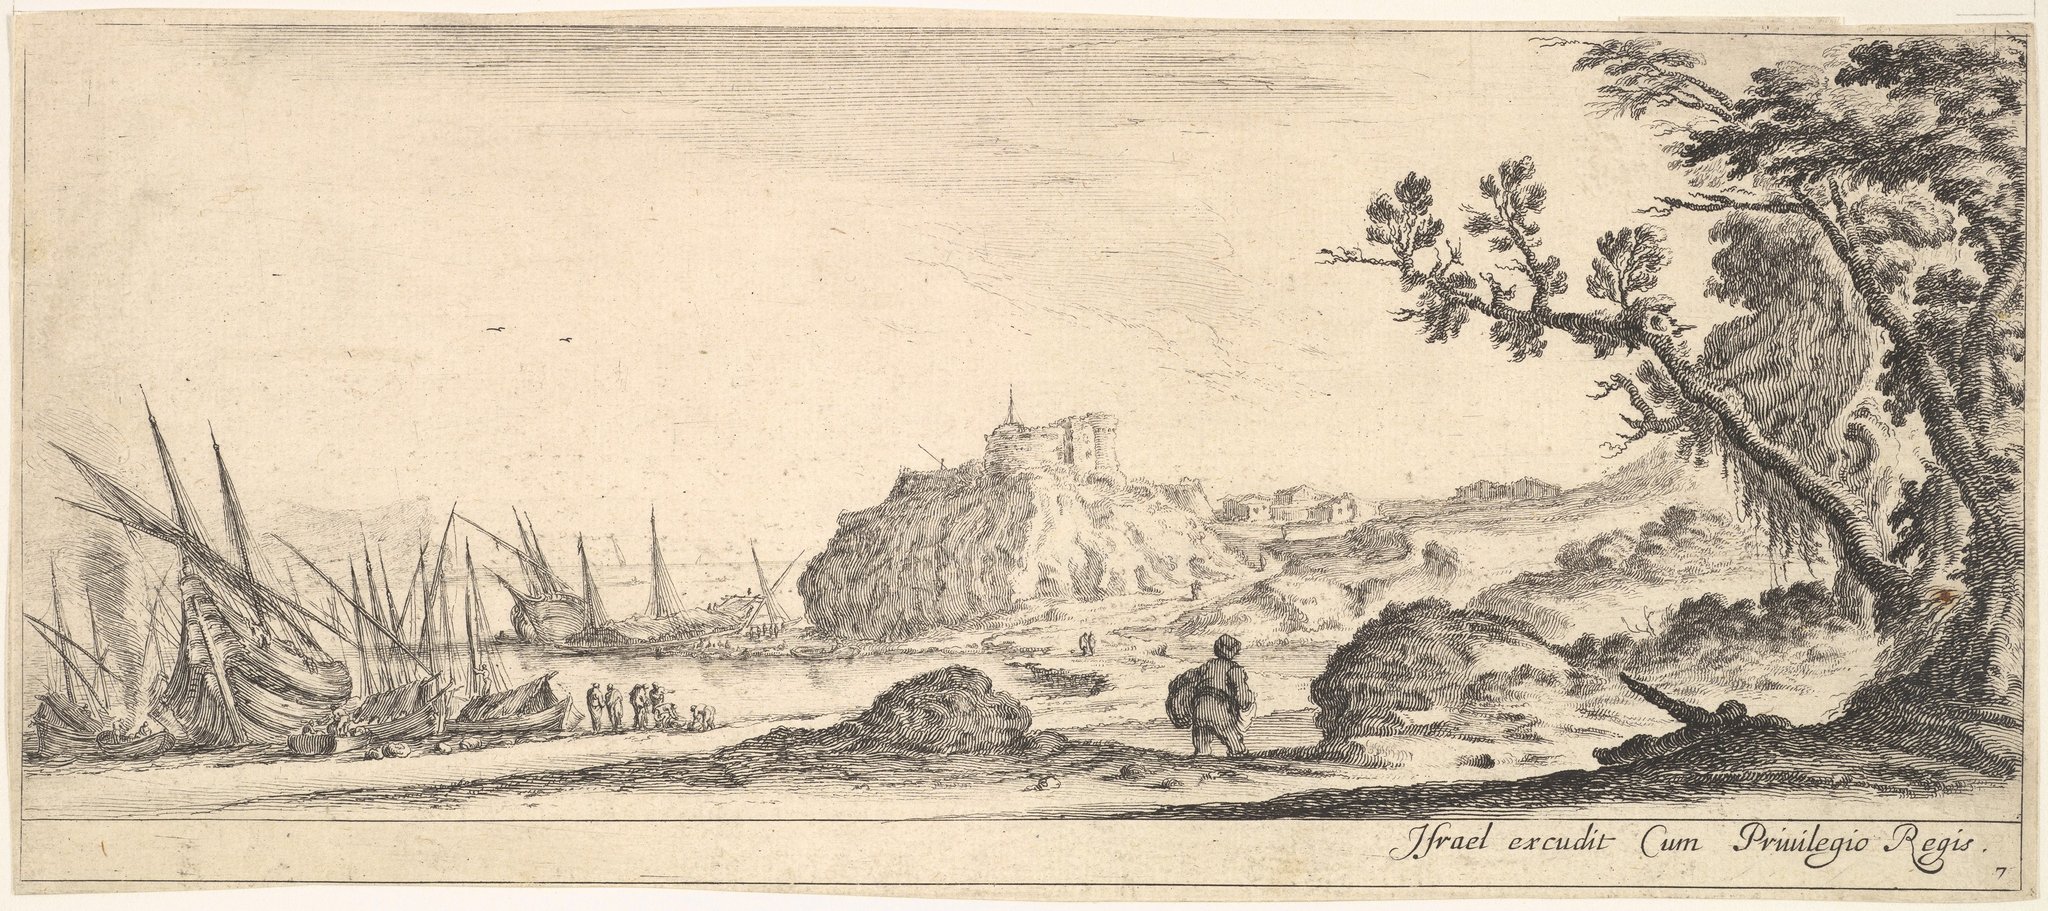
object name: print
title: Plate 7: various boats on shore to left, a man carrying a bag, seen from behind and walking towards the background, a fortress in center background, a tree to the right, from "Various Landscapes" (Divers Paysages)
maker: stefano della bella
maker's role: artist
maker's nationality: italian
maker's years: 1610-1664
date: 1641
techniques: etching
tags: men,landscapes,boats